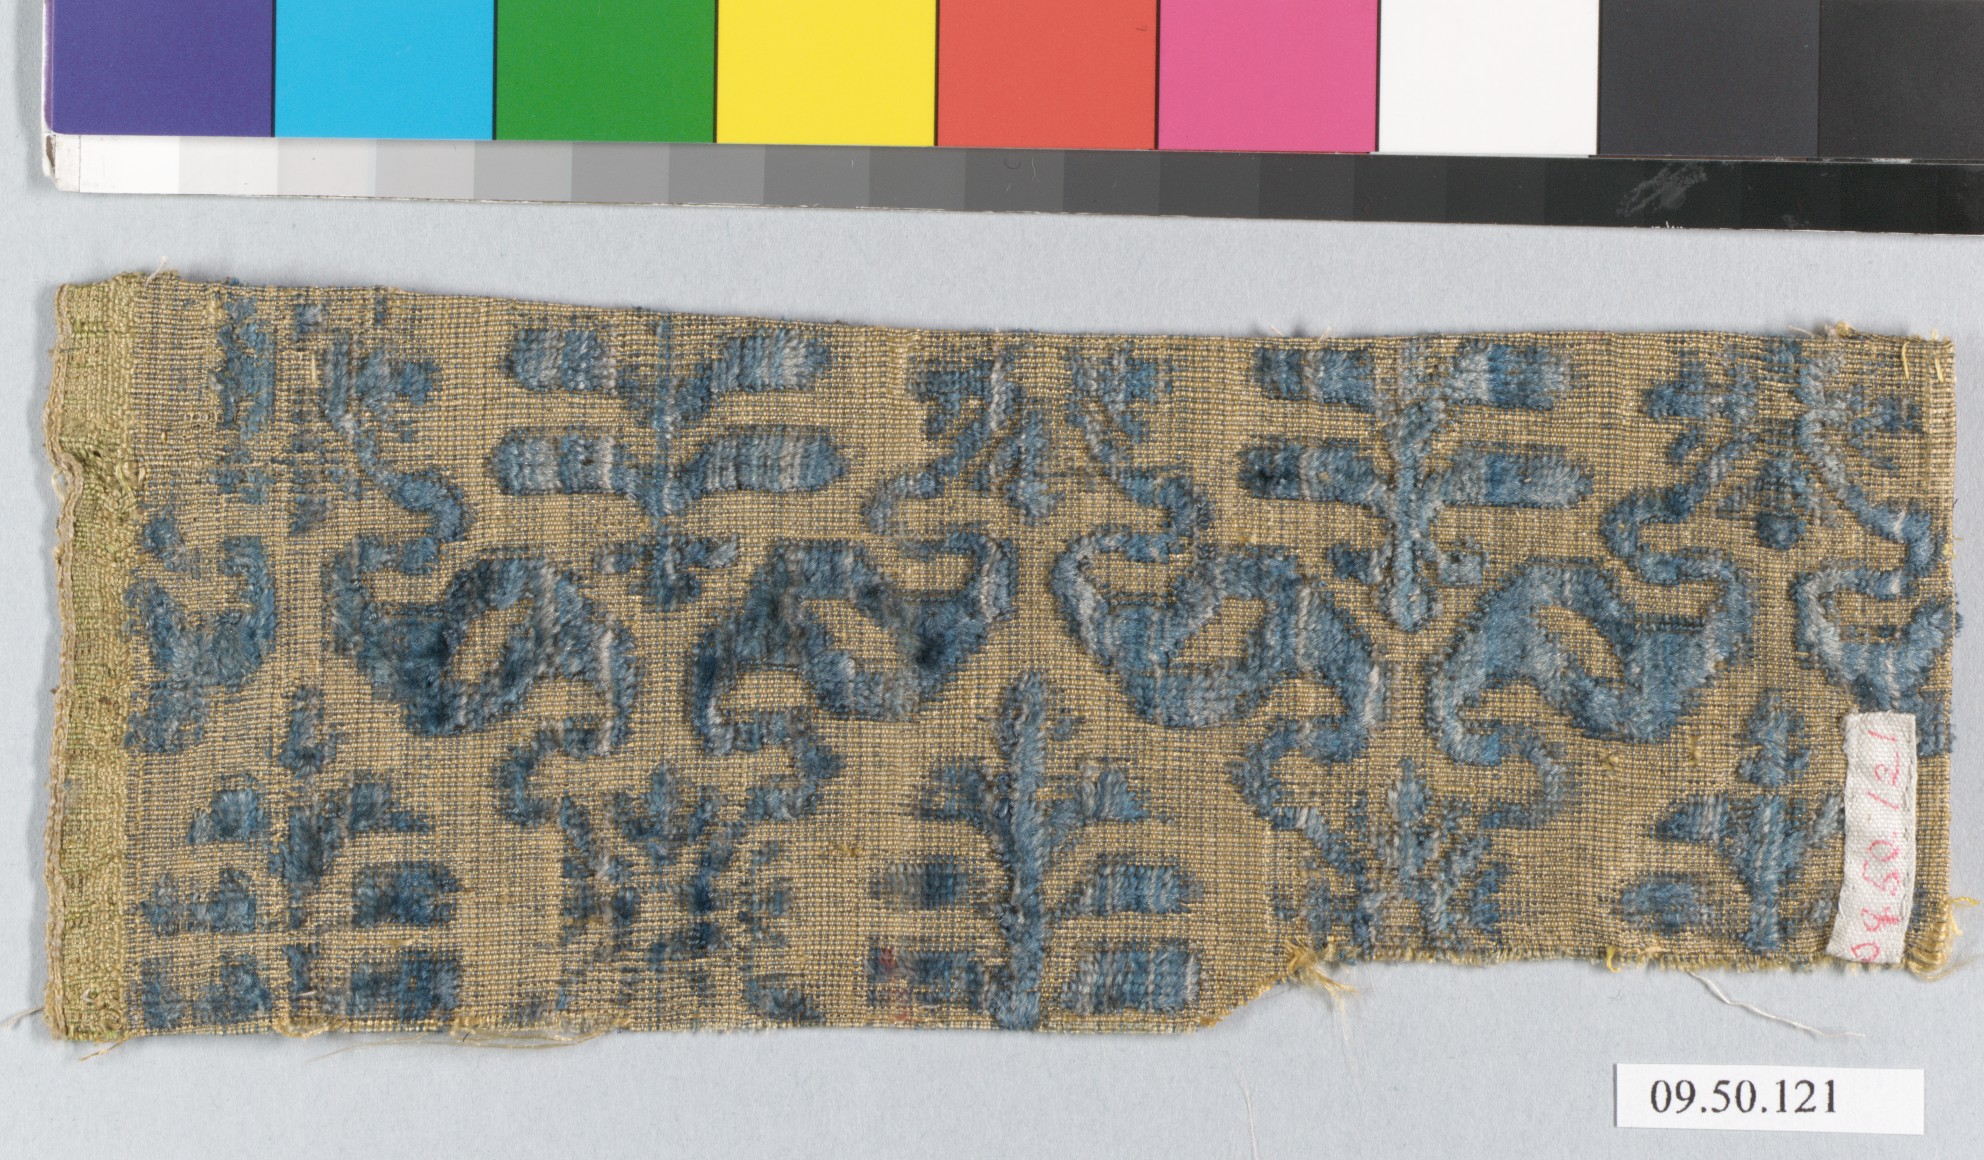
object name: piece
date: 1501-1700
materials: silk